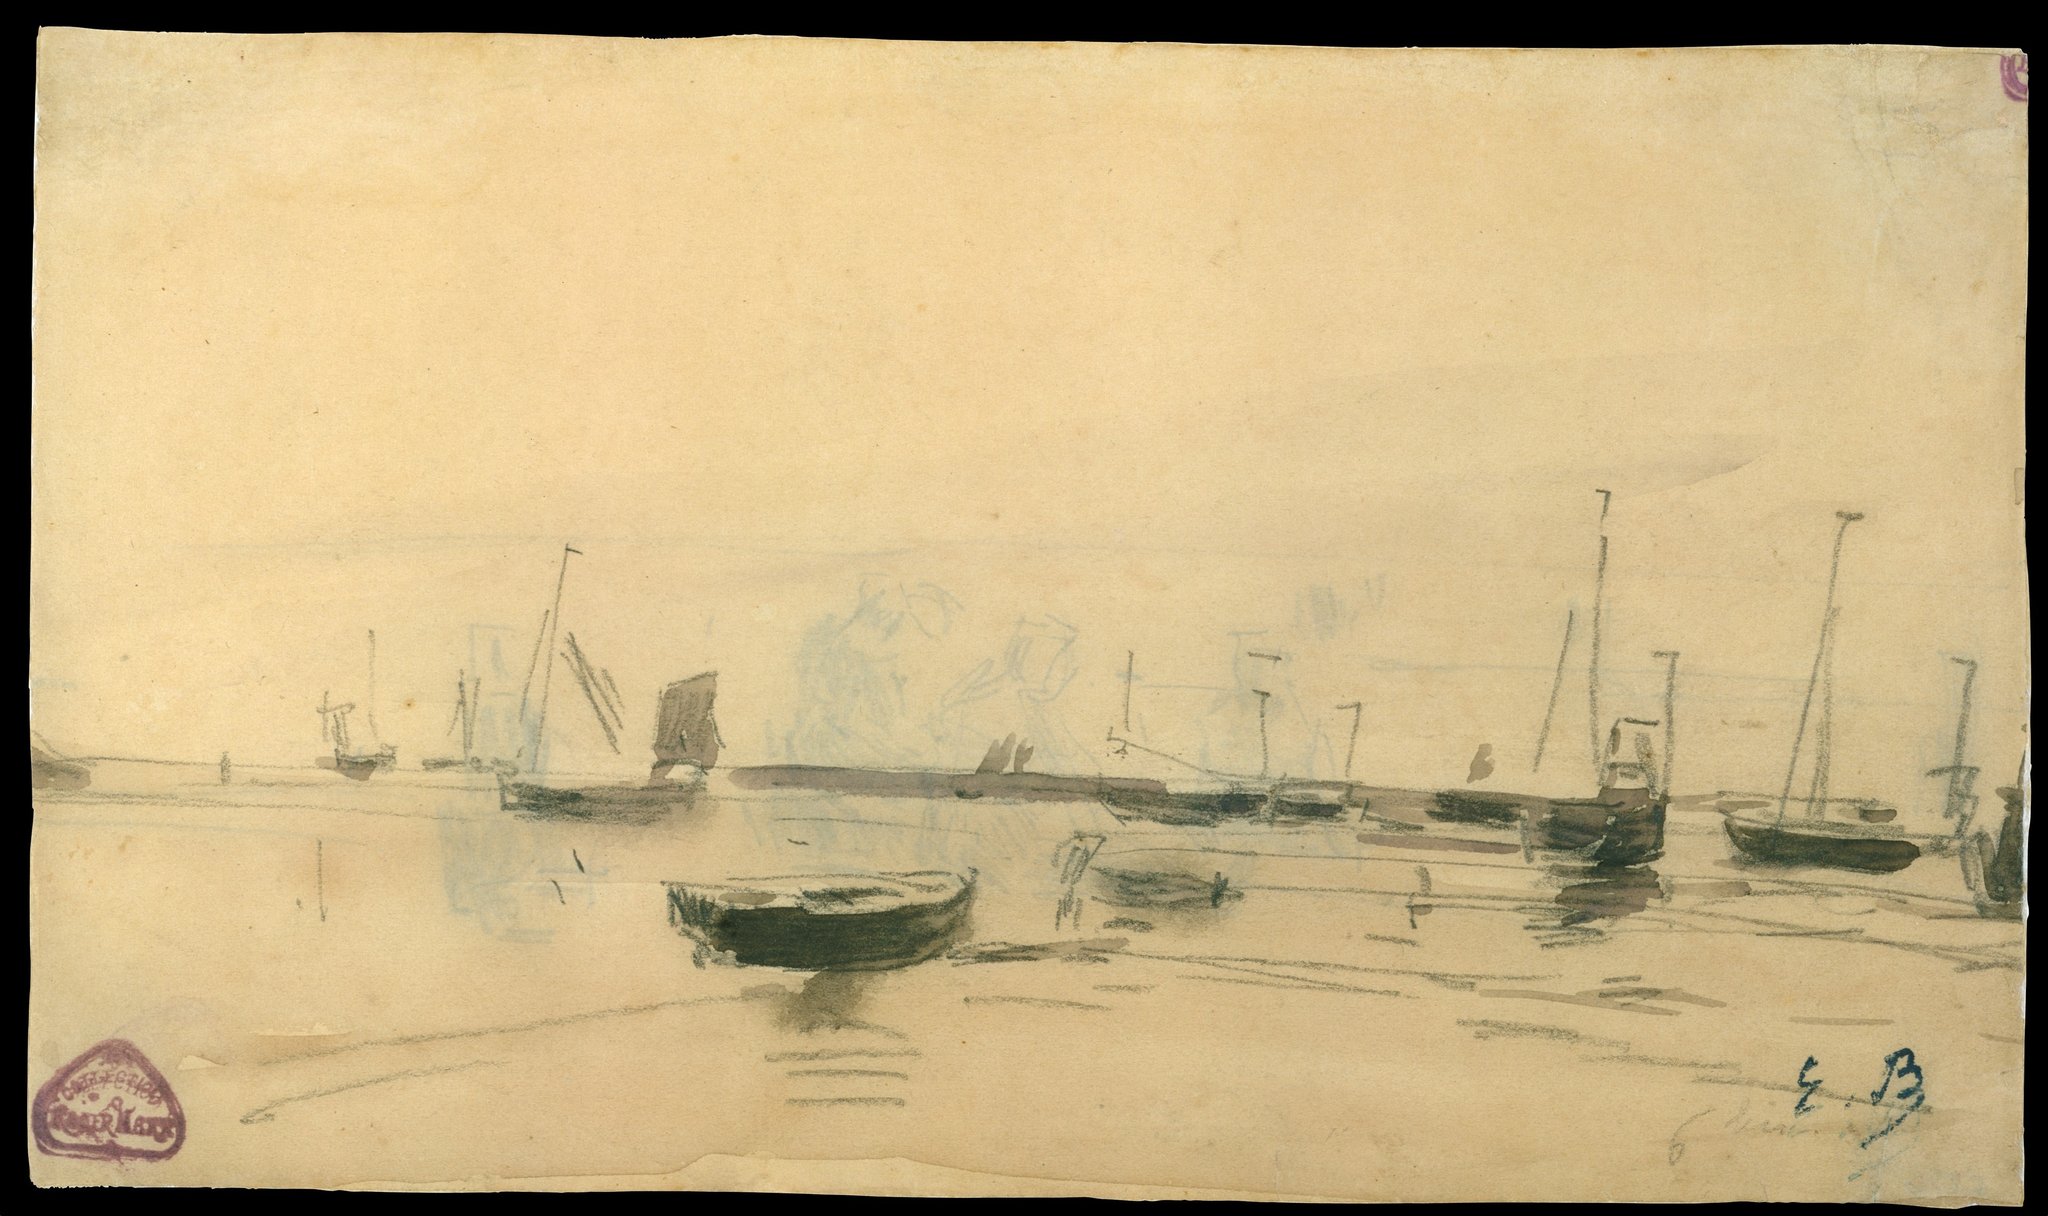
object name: drawing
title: Marine Scene (recto)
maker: eugène boudin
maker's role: artist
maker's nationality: french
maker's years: 1824-1898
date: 1870-1885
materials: graphite, watercolor, paper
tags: seascapes,boats